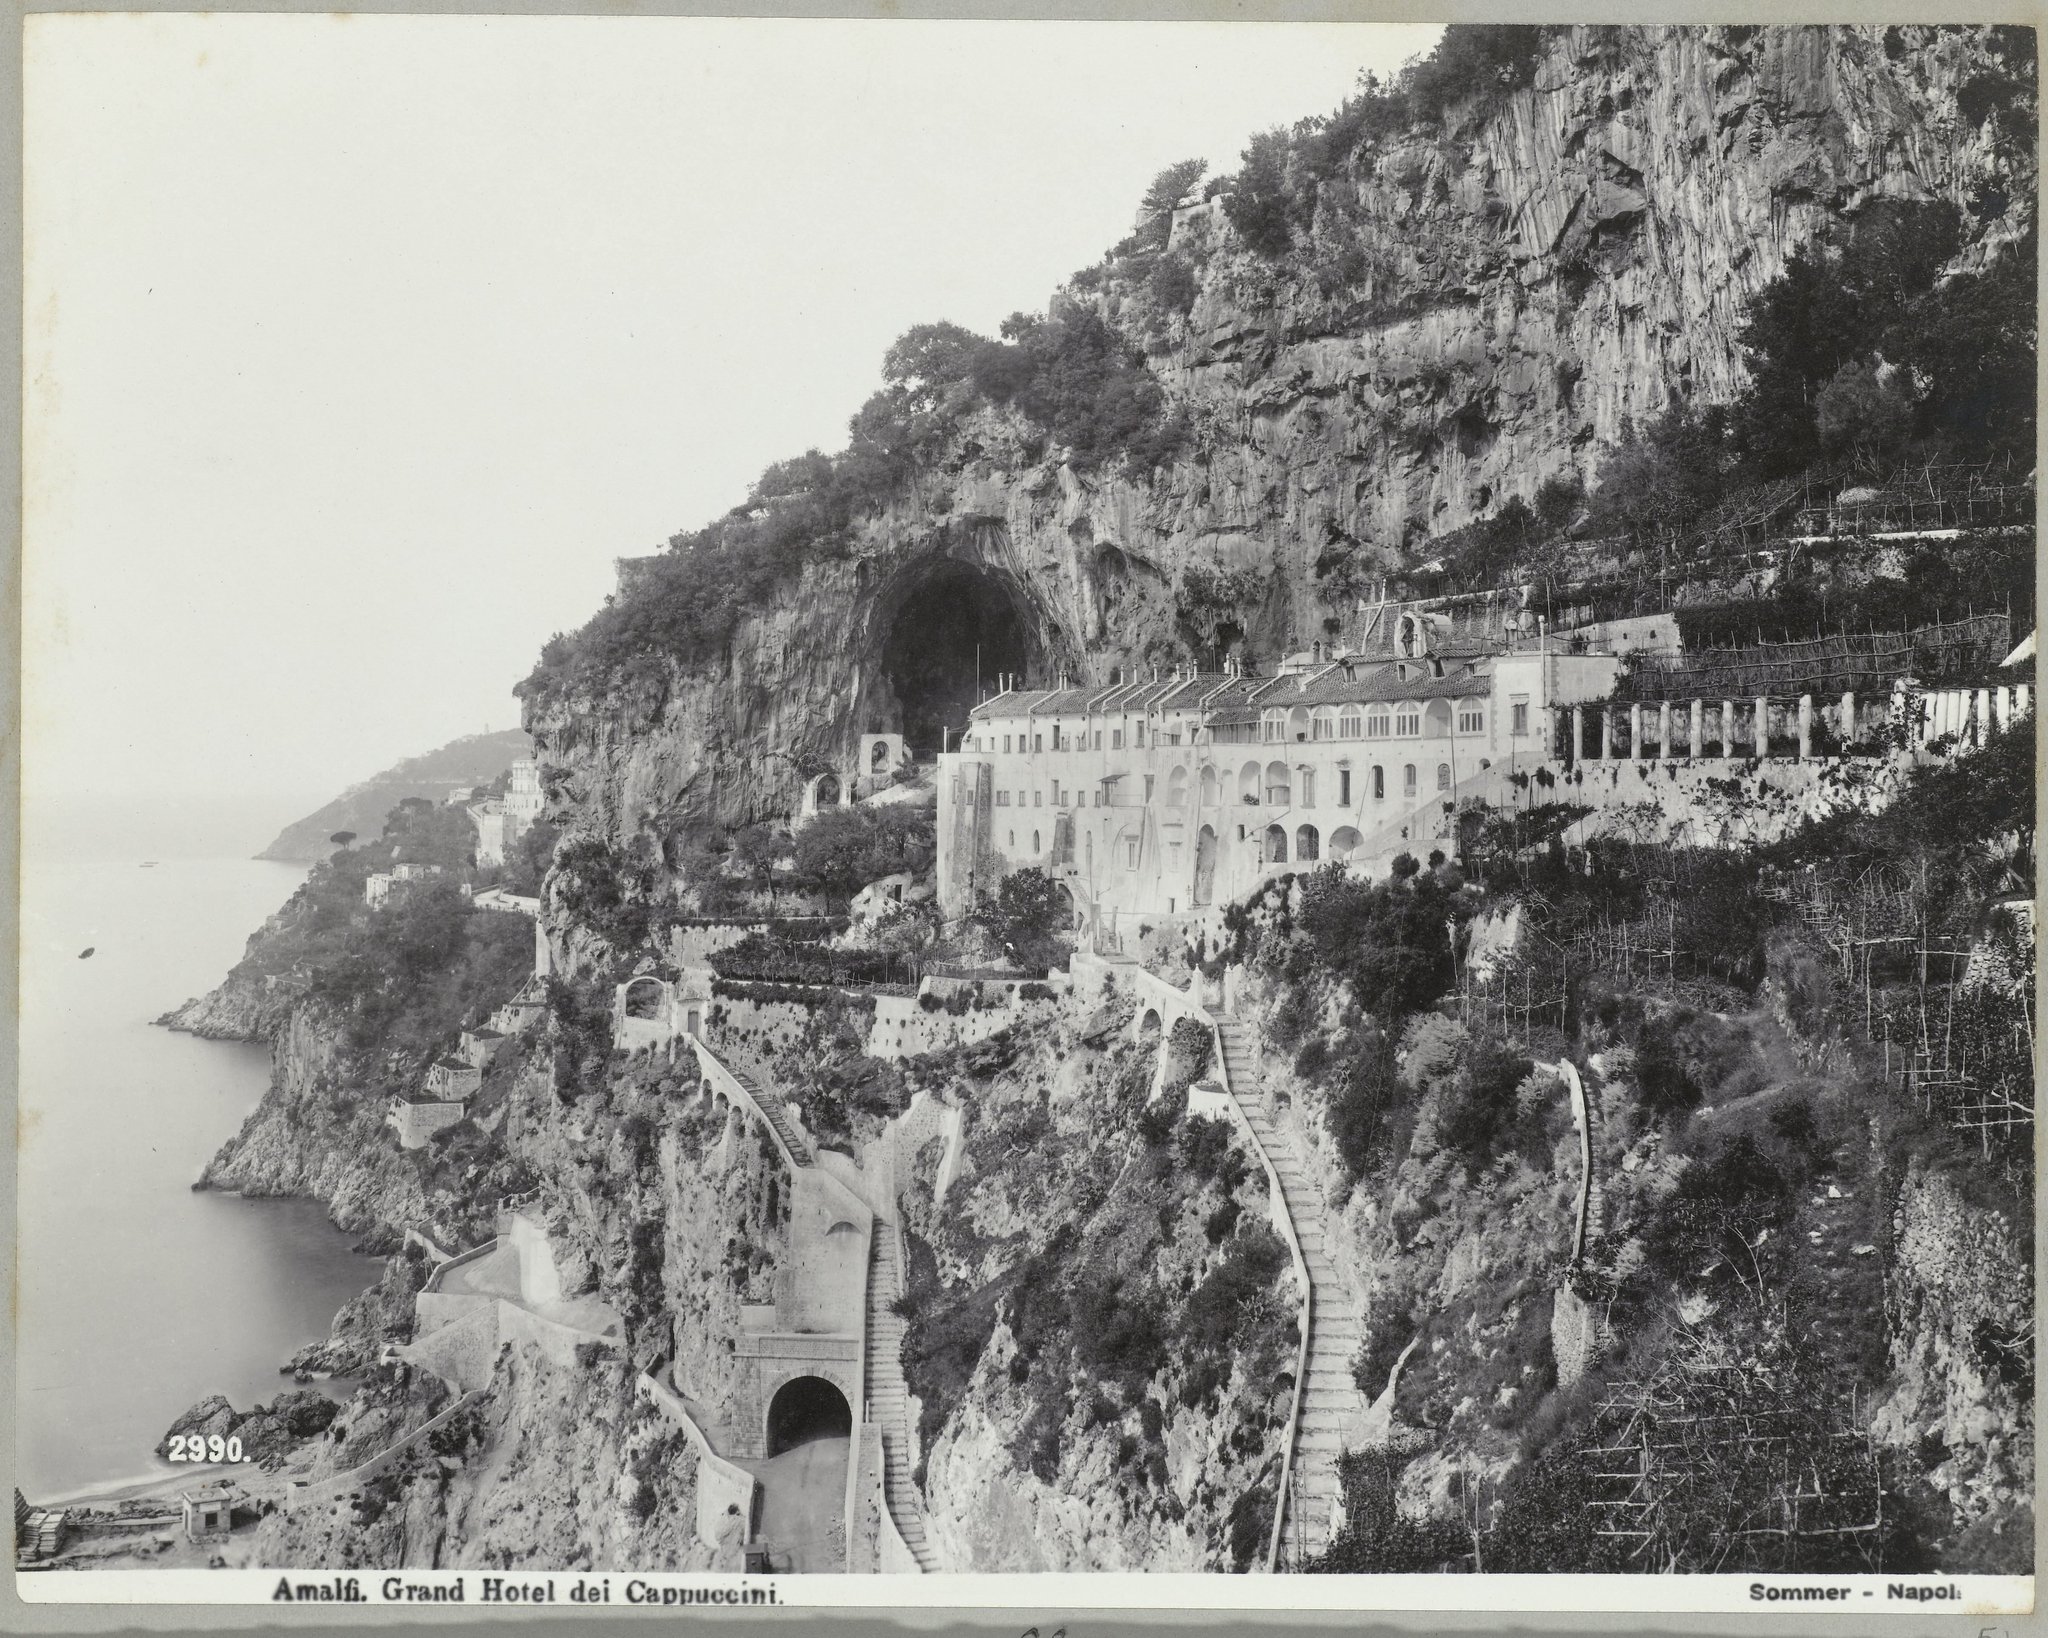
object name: photograph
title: 2990 Amalfi Grand Hotel dei Cappuccini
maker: giorgio sommer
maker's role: fotograaf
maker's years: 1834-1914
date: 1888-1903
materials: cardboard, photographic support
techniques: albumen print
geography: netherlands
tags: amalfi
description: Een verblijf van de Capucijner aan de bergwand boven de stad Amalfi.